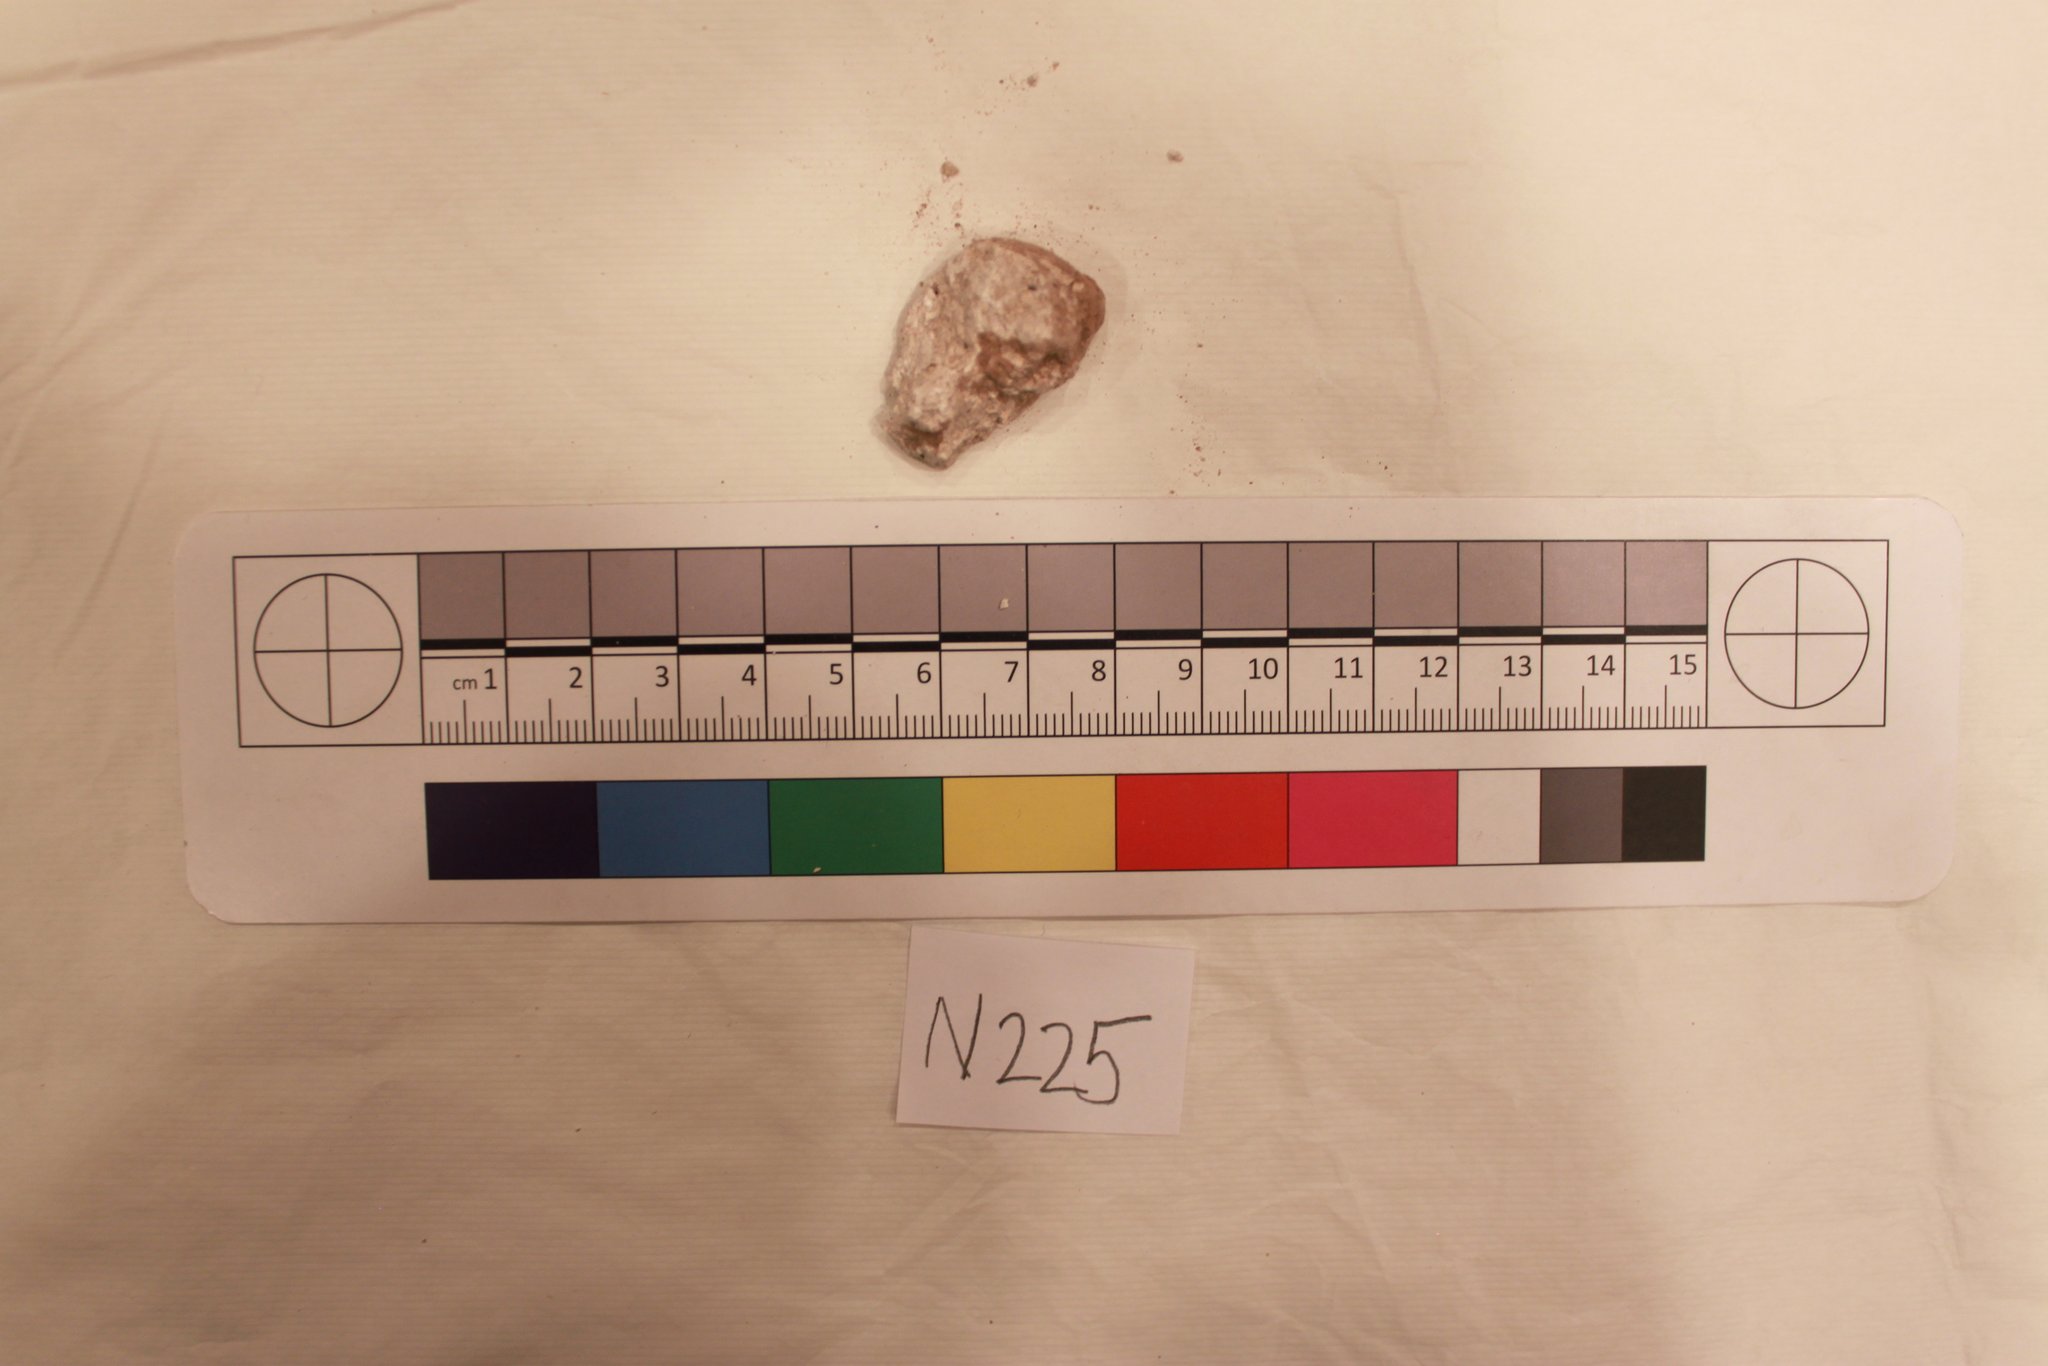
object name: fragment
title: Stucco Fragment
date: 701-1200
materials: plaster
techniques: carving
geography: iran